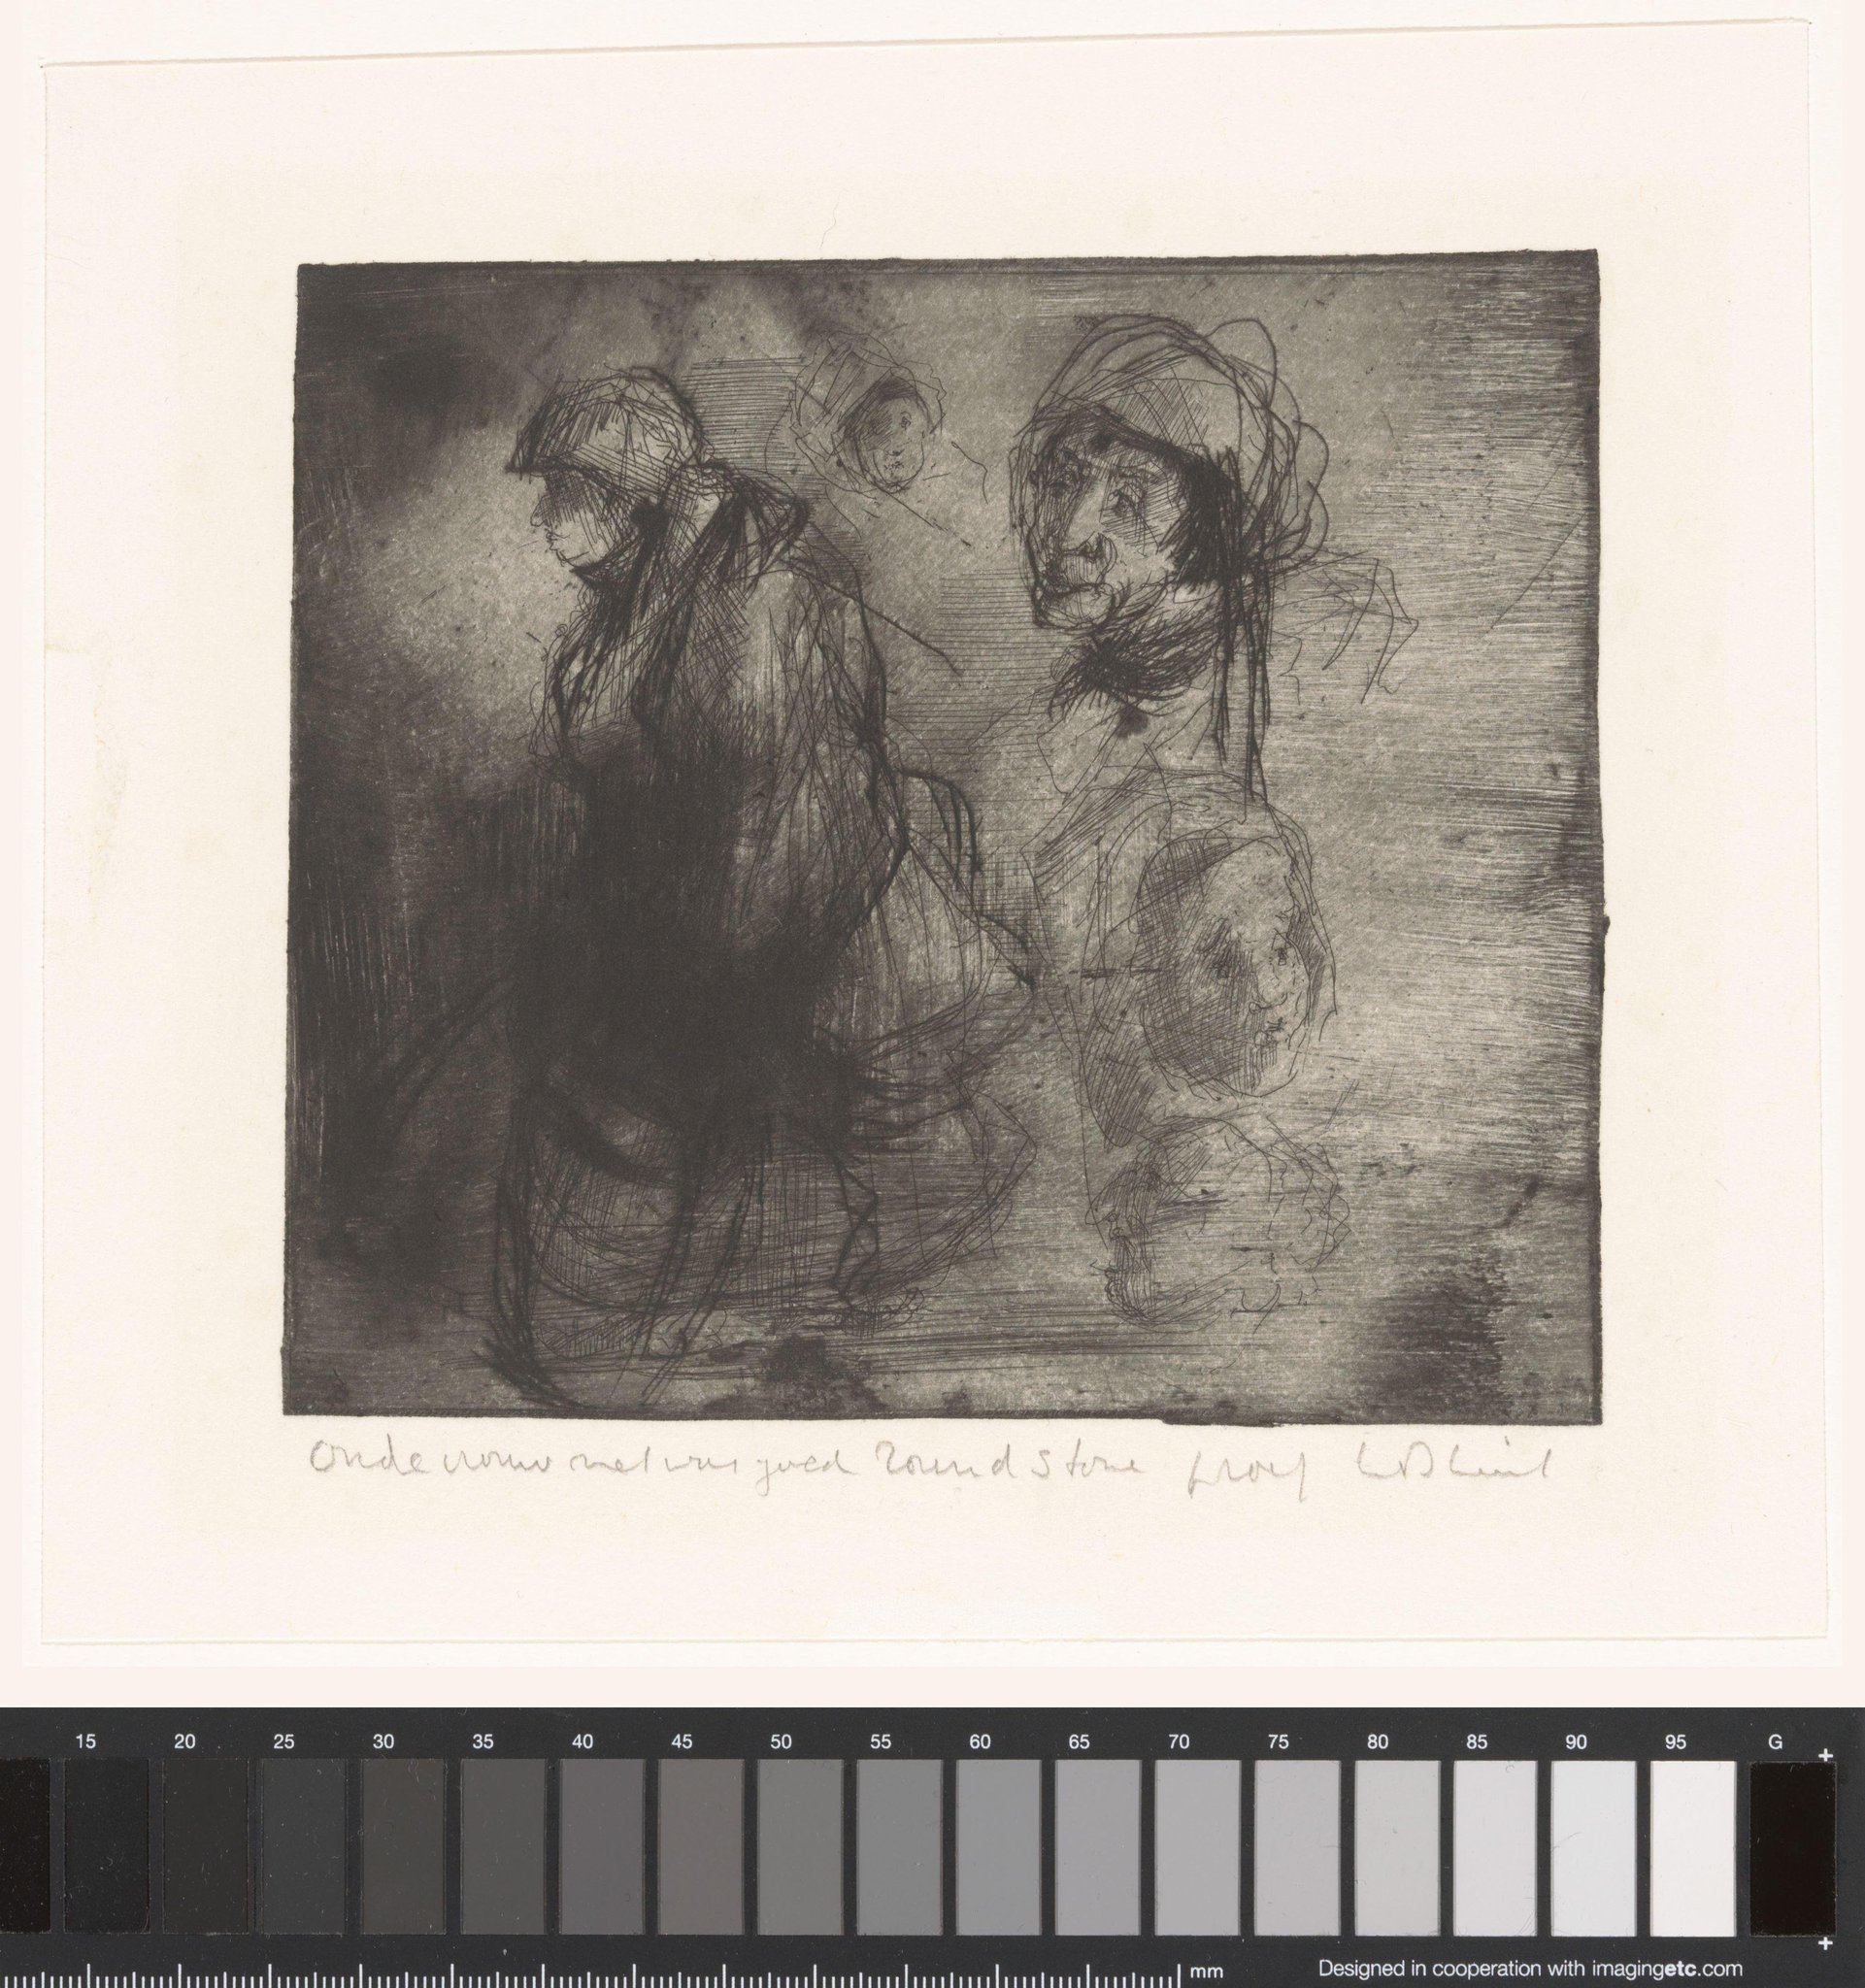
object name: print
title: Oude vrouw met wasgoed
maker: dirkje kuik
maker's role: print maker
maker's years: 1929-2008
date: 1950-1971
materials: ink, paper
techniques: aquatint, etching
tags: wash house, home laundry, laundry room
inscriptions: title: ‘oude vrouw met wasgoed’, edition: ‘roundstone proef’, signature: ‘WD Kuik’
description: Oude vrouw met wasgoed schetsmatig weergegeven, met rechts enkele studiekoppen.